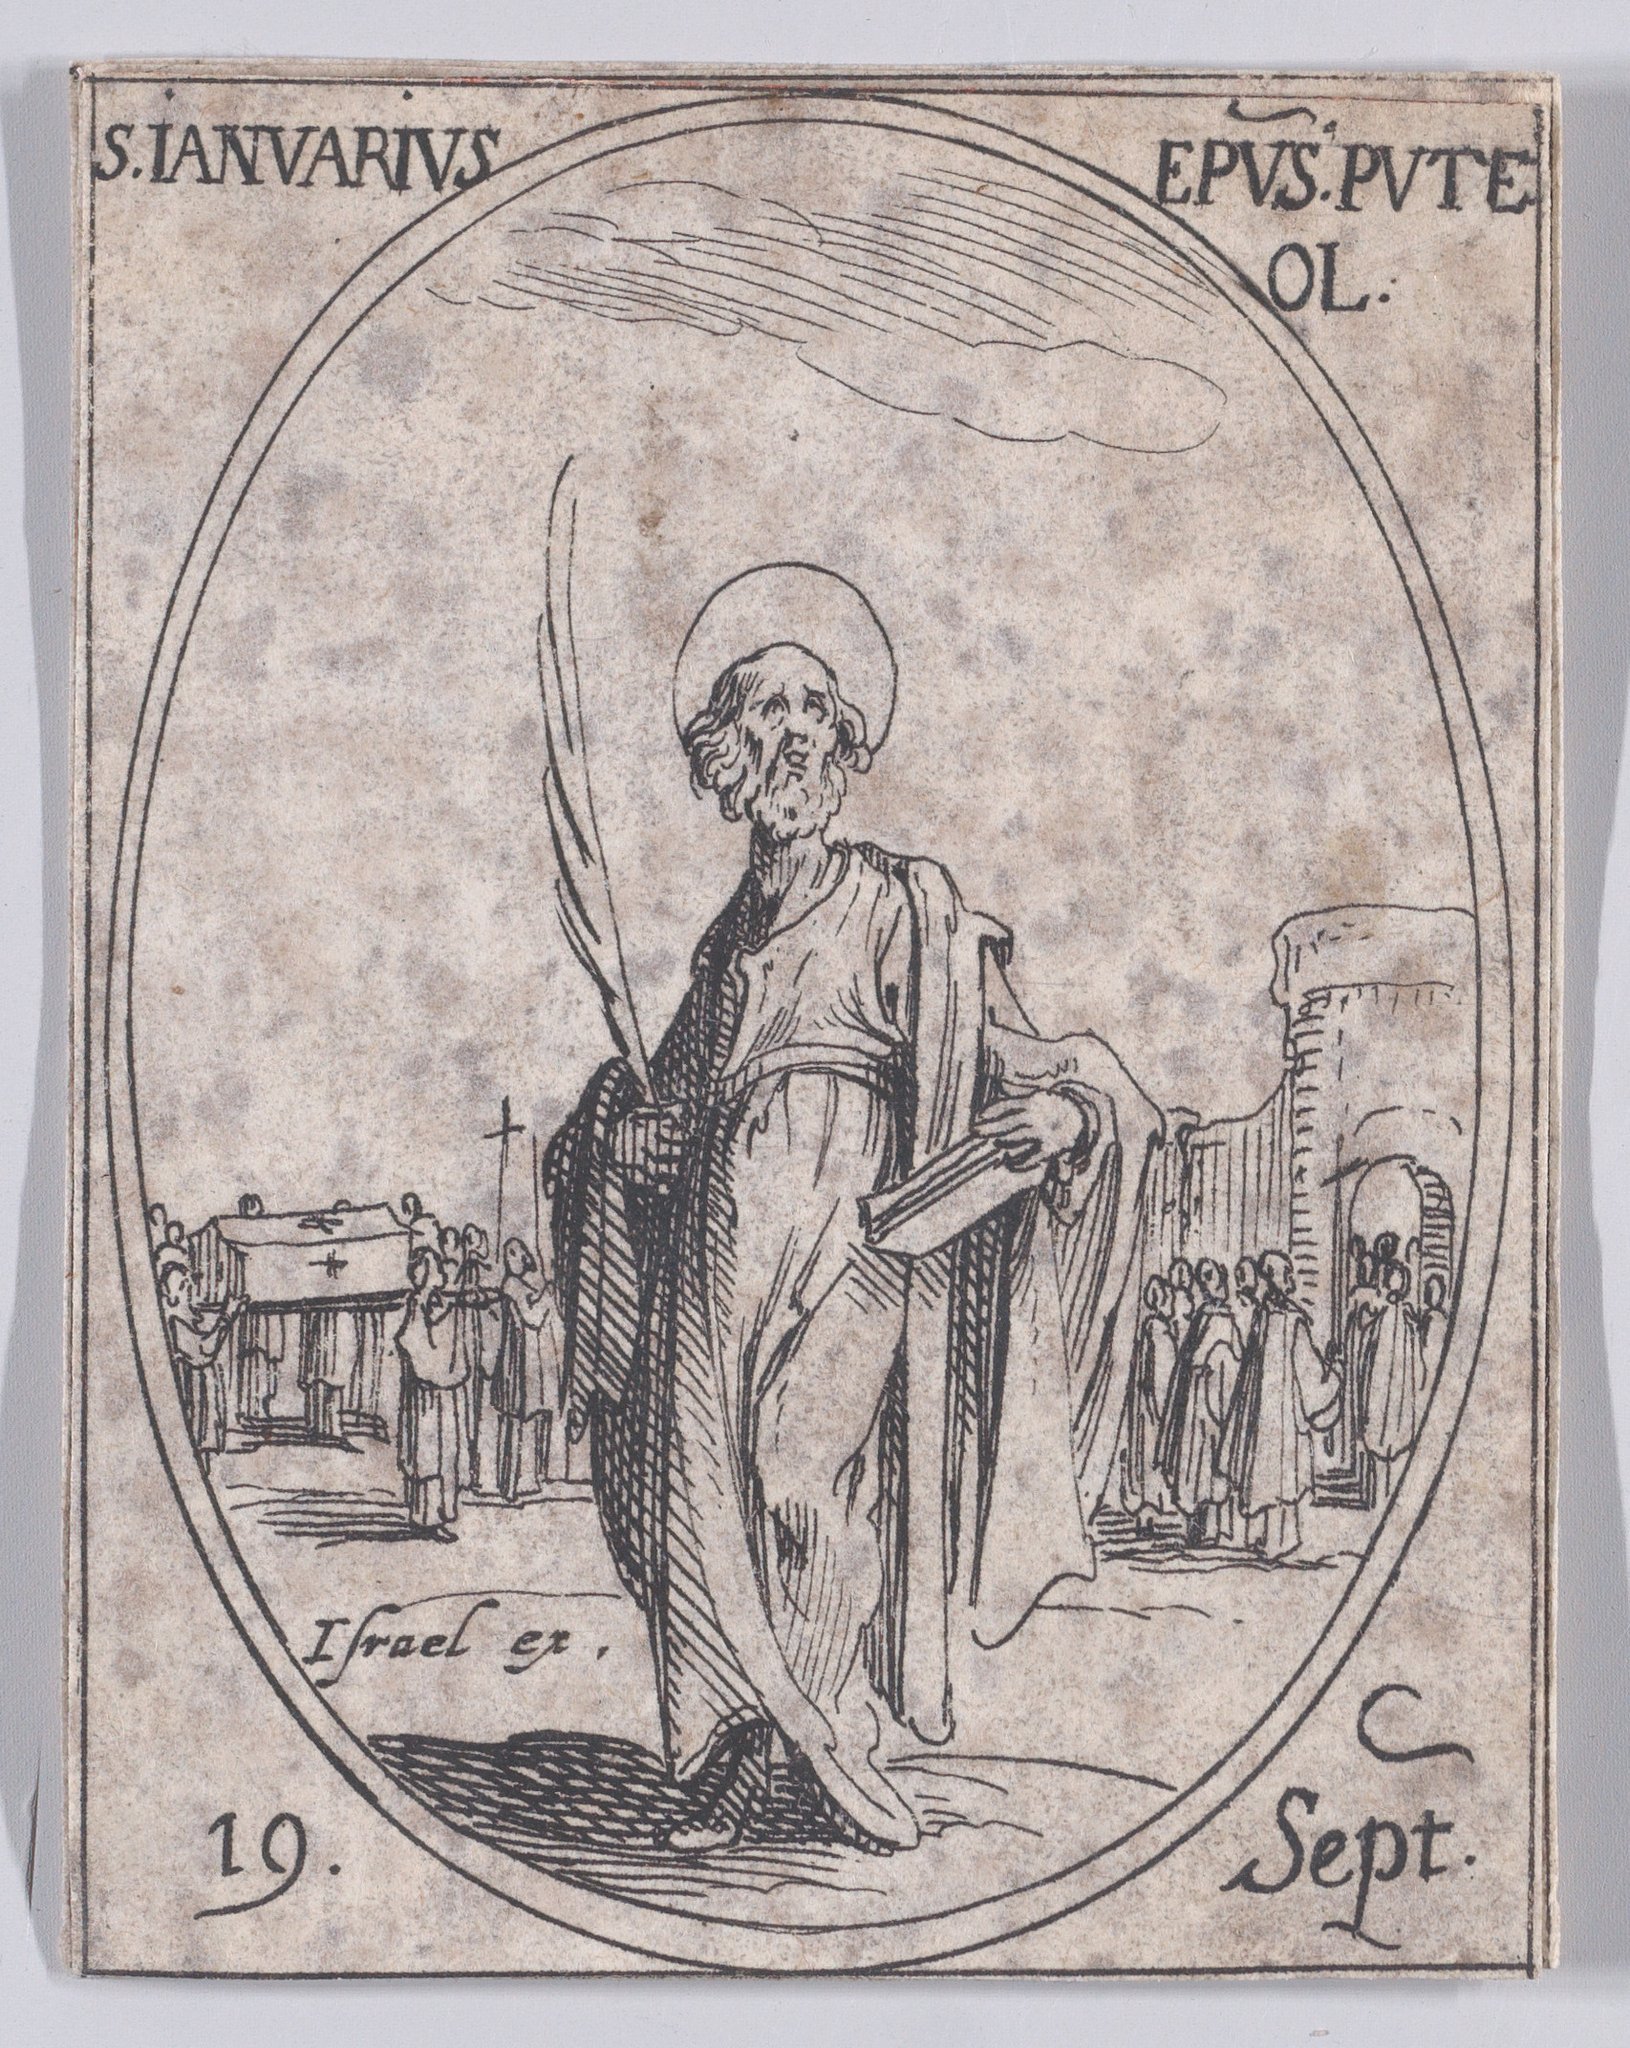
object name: print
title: S. Janvier, évêque de Pouzzoles (St. Januarius, Bishop of Pouzzoles), September 19th, from "Les Images De Tous Les Saincts et Saintes de L'Année" (Images of All of the Saints and Religious Events of the Year)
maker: jacques callot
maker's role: artist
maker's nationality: french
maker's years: 1592-1635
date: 1636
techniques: etching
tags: men,saints